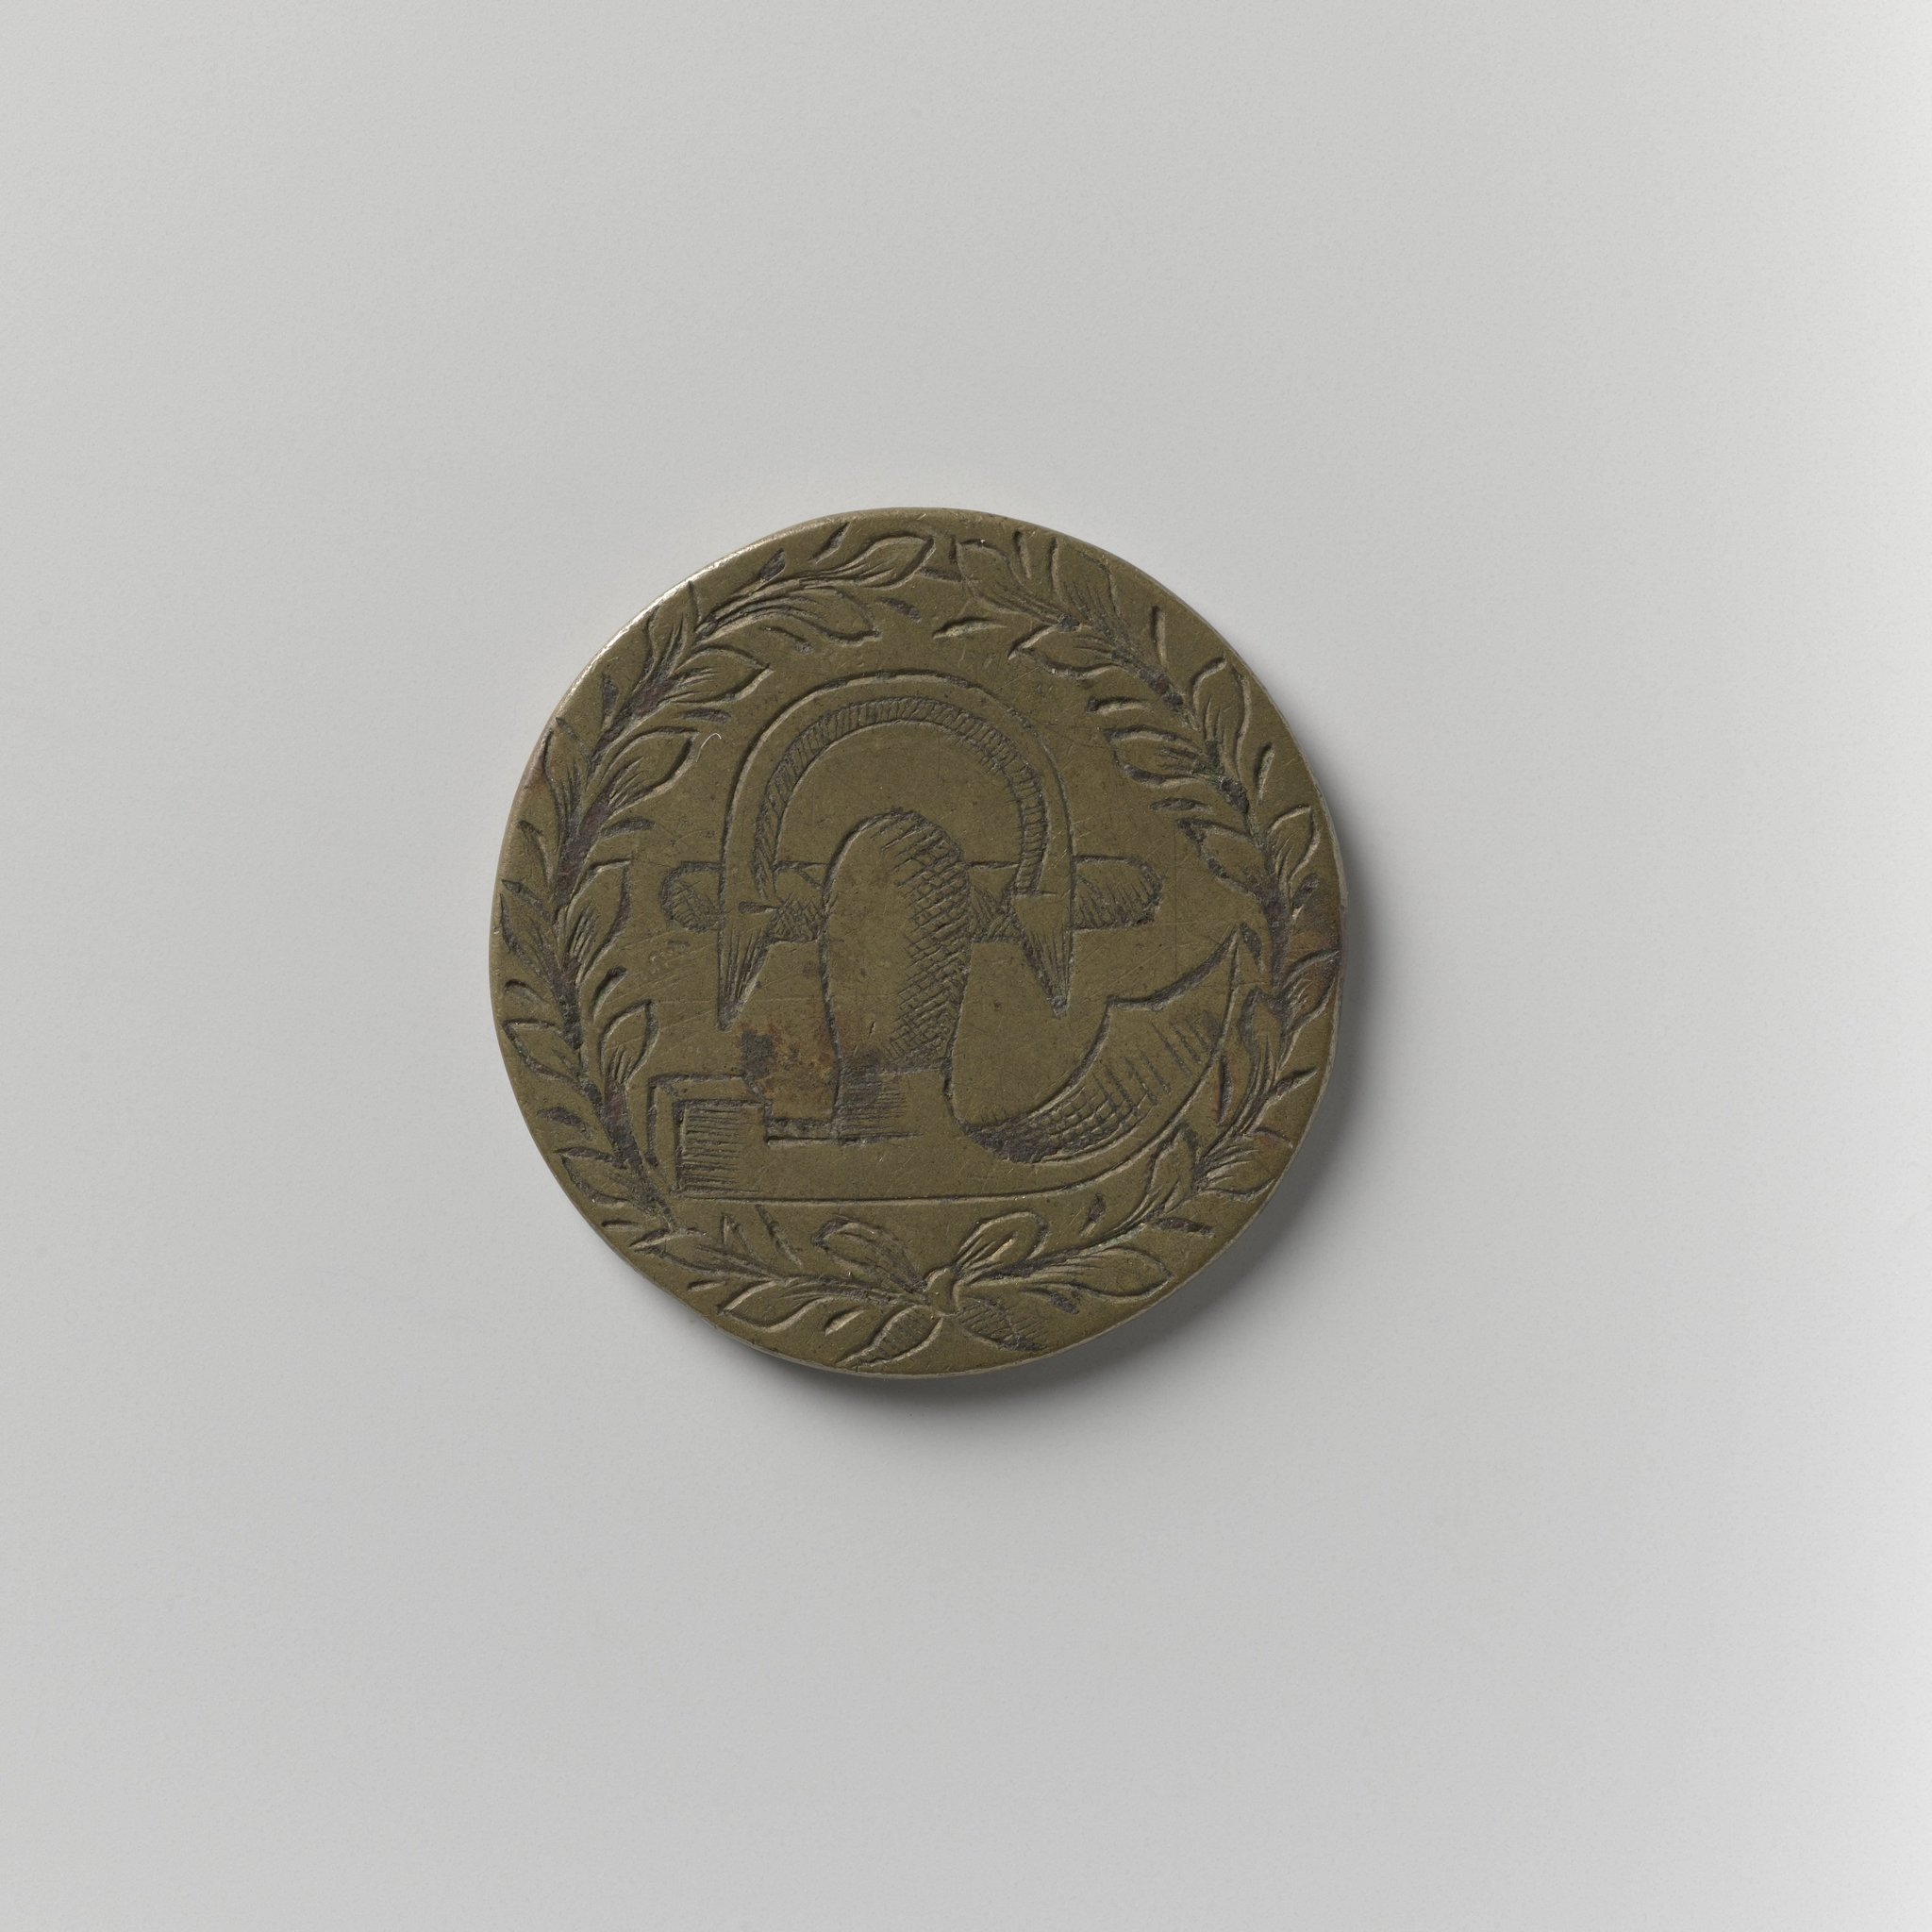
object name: medal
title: Kuipers- en wijnverlatersgilde van Amsterdam, gildepenning van Jan Courten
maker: Anonymous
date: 1664-1715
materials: brass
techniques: engraving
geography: amsterdam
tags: amsterdam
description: Messing penning. Voorzijde: dissel en passer binnen bladerkrans. Keerzijde: opschrift